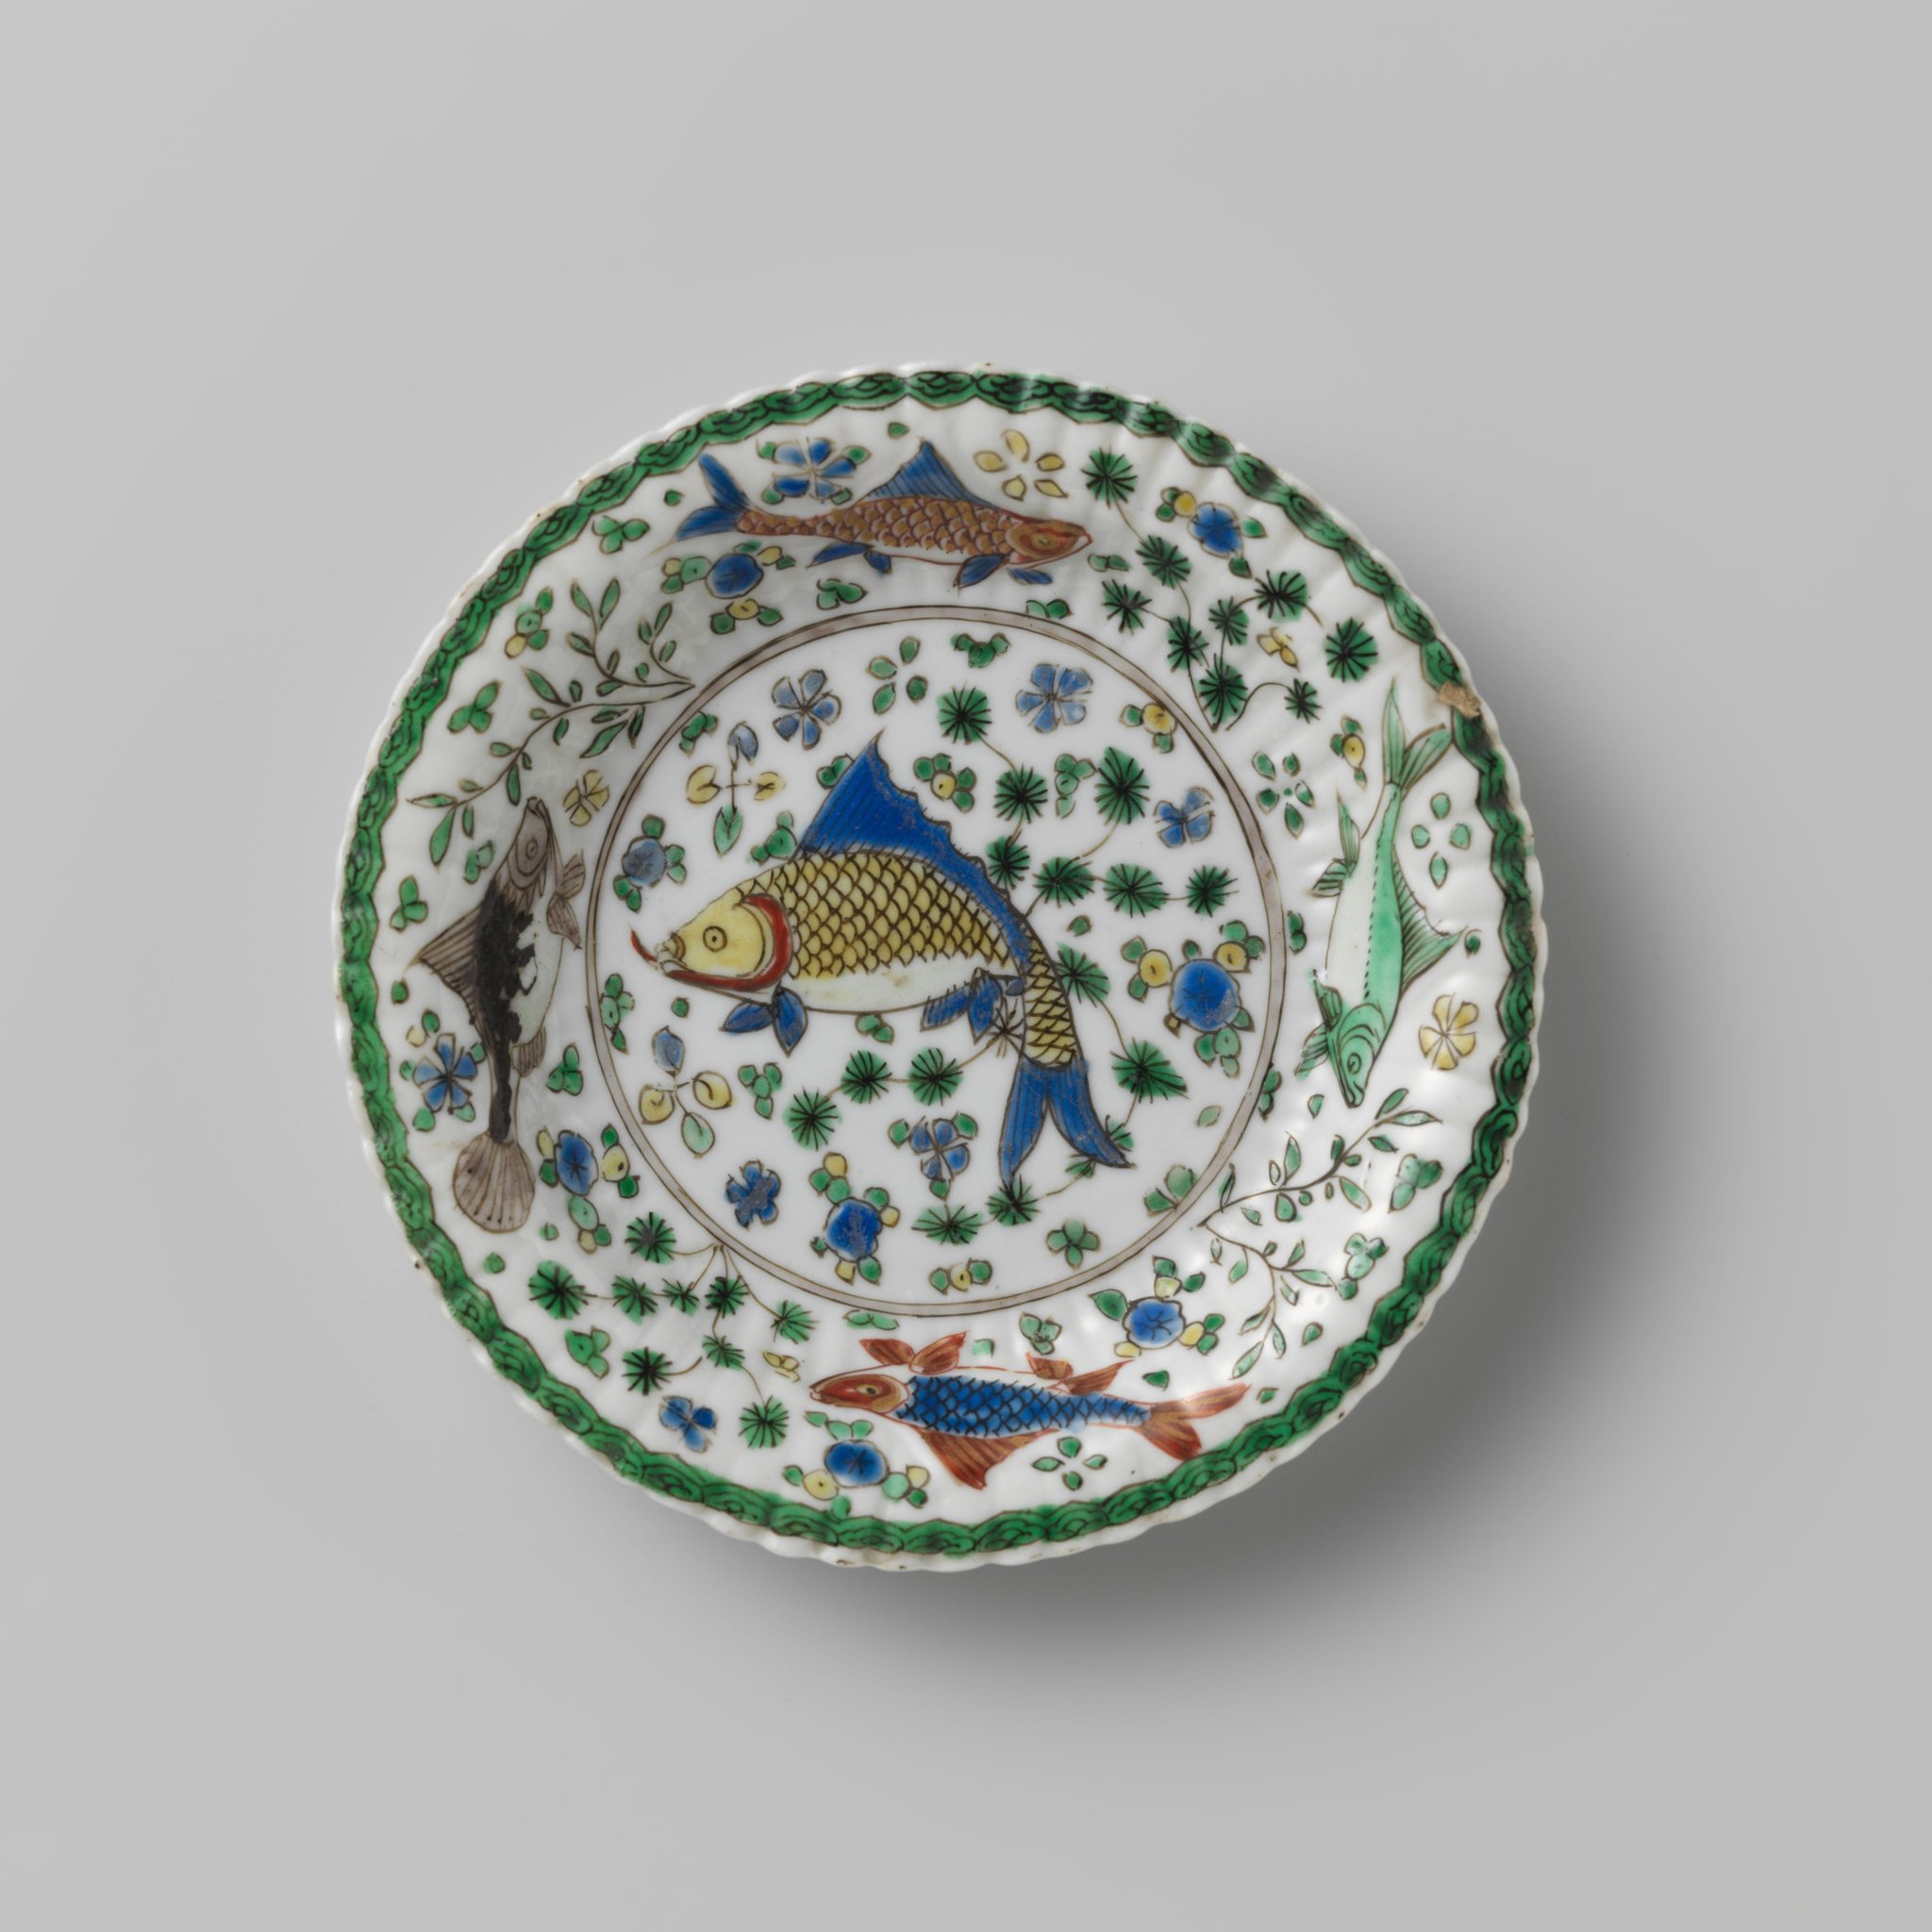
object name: platter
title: Saucer with fish between water plants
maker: Anonymous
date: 1700-1724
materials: cobalt, glaze, gold, paint, porcelain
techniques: firing, turning, vitrification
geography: china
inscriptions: mark: ‘玉’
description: Schotel van porselein met geribde wand en gelobde rand, beschilderd in onderglazuur blauw en op het glazuur blauw, rood, groen, geel, aubergine, zwart en goud. Het plat van de schotel met een vis tussen waterplanten en vier kleinere vissen tussen waterplanten op de wand en rand, de rand met een band ruyi-motief; op de buitenzijde vier vissen in ijzerrood. Gemerkt op de onderzijde met 'Yù', jade, in een dubbele cirkel. Famille verte.